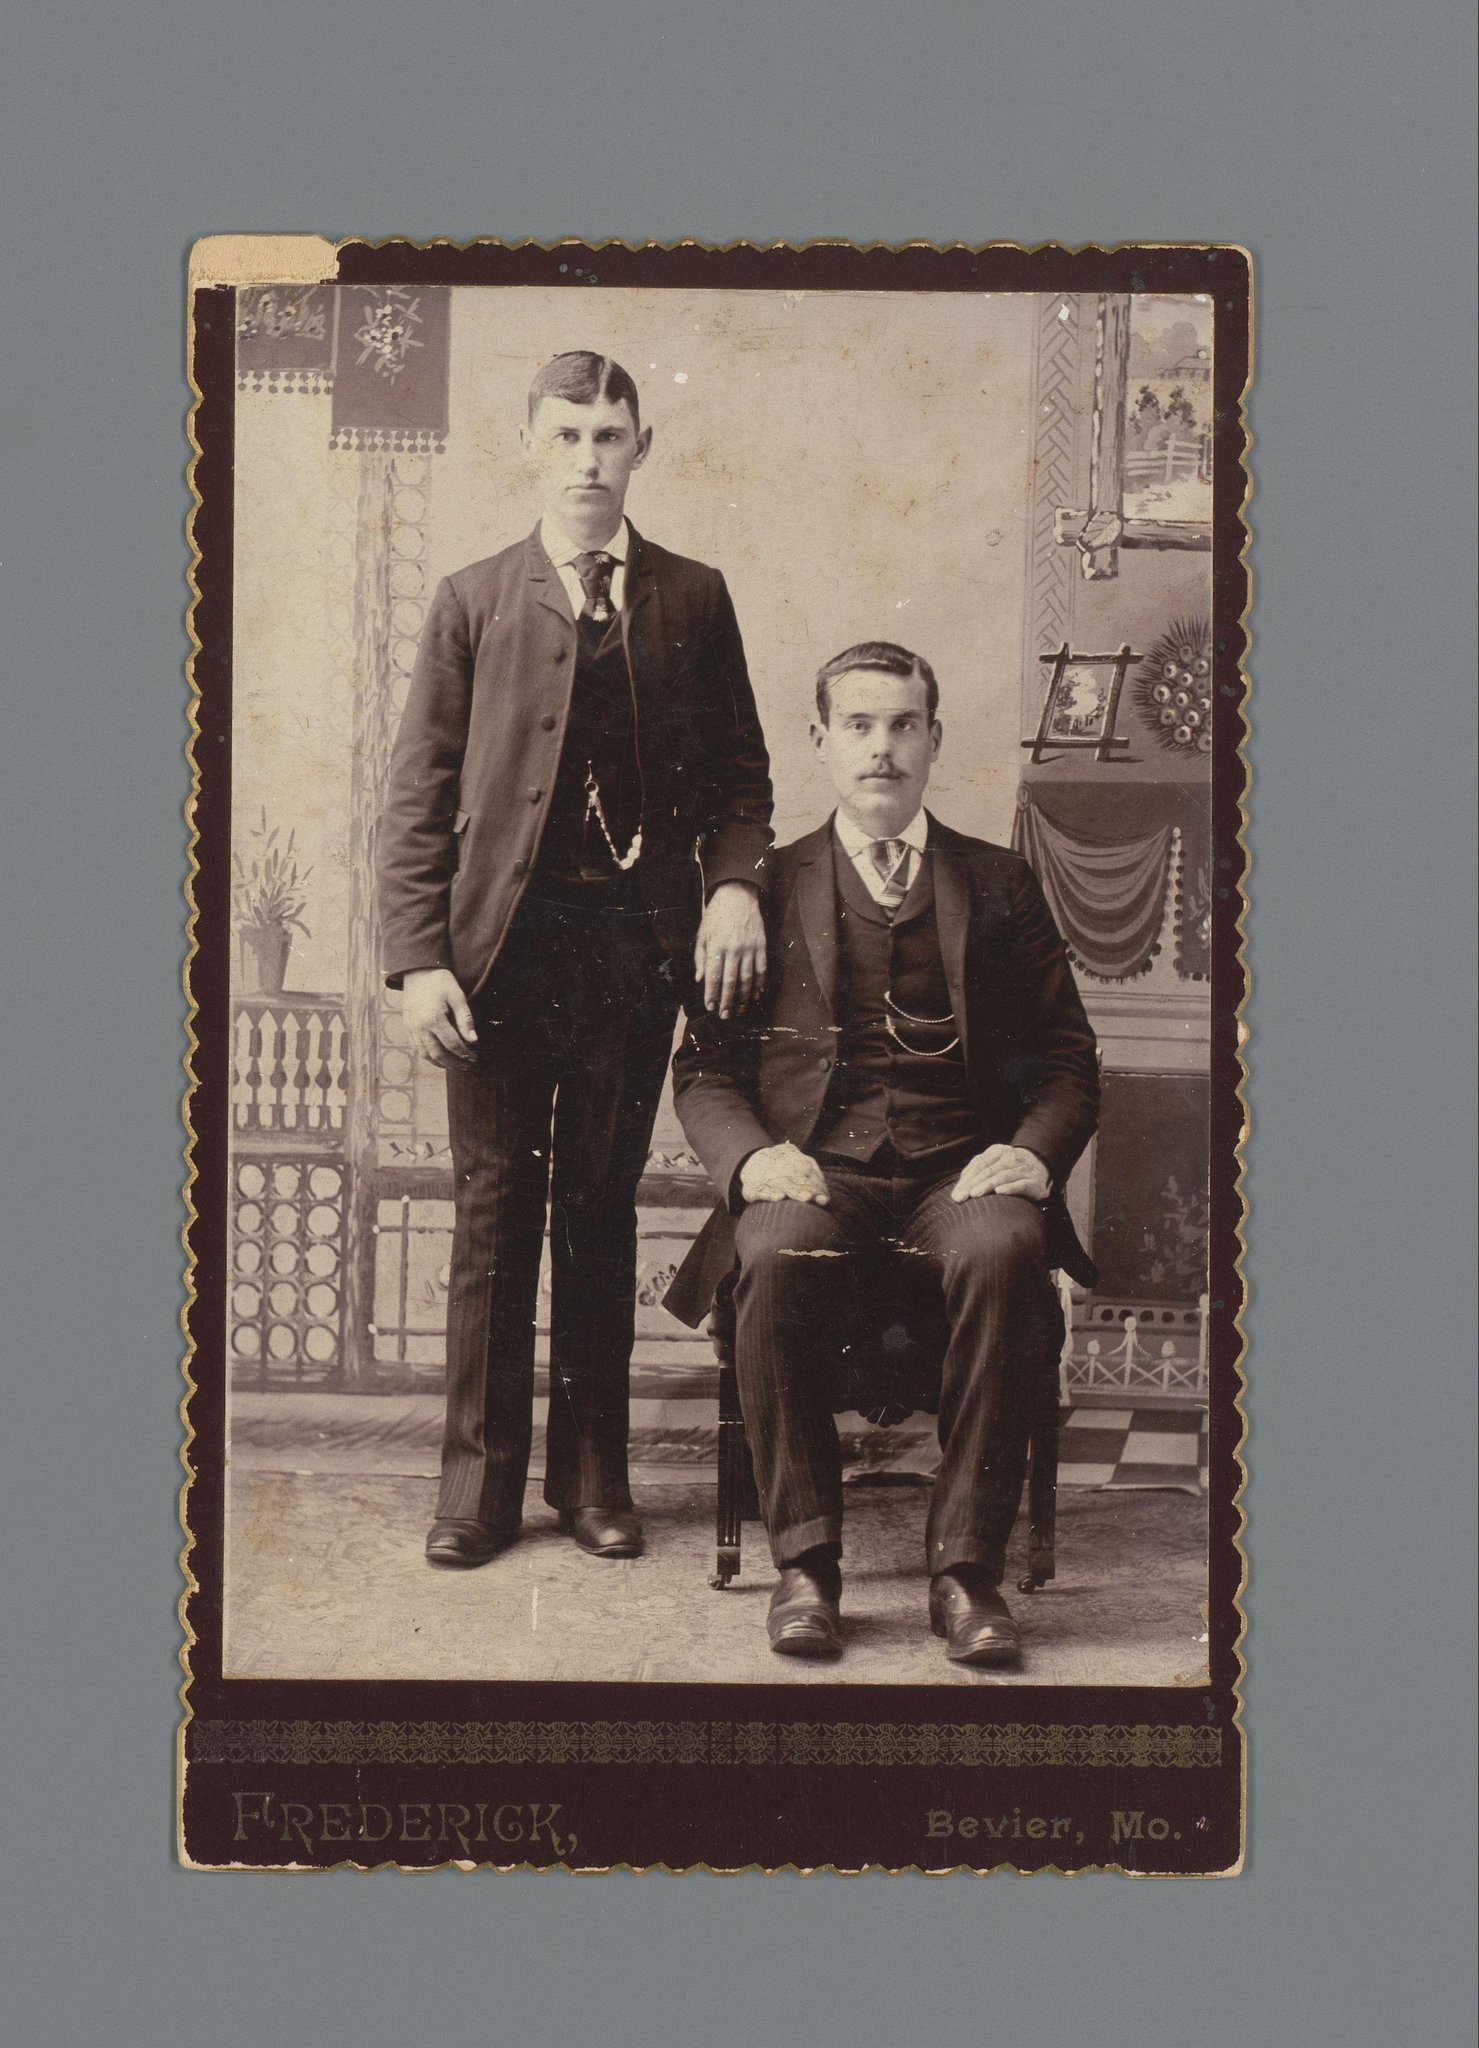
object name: cabinet photograph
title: Portret van twee onbekende jonge mannen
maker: b. frederick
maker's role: fotograaf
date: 1880-1910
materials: paper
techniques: collodion silver print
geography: bevier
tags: adult man, anonymous historical person portrayed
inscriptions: inscription: ‘EC $6-’